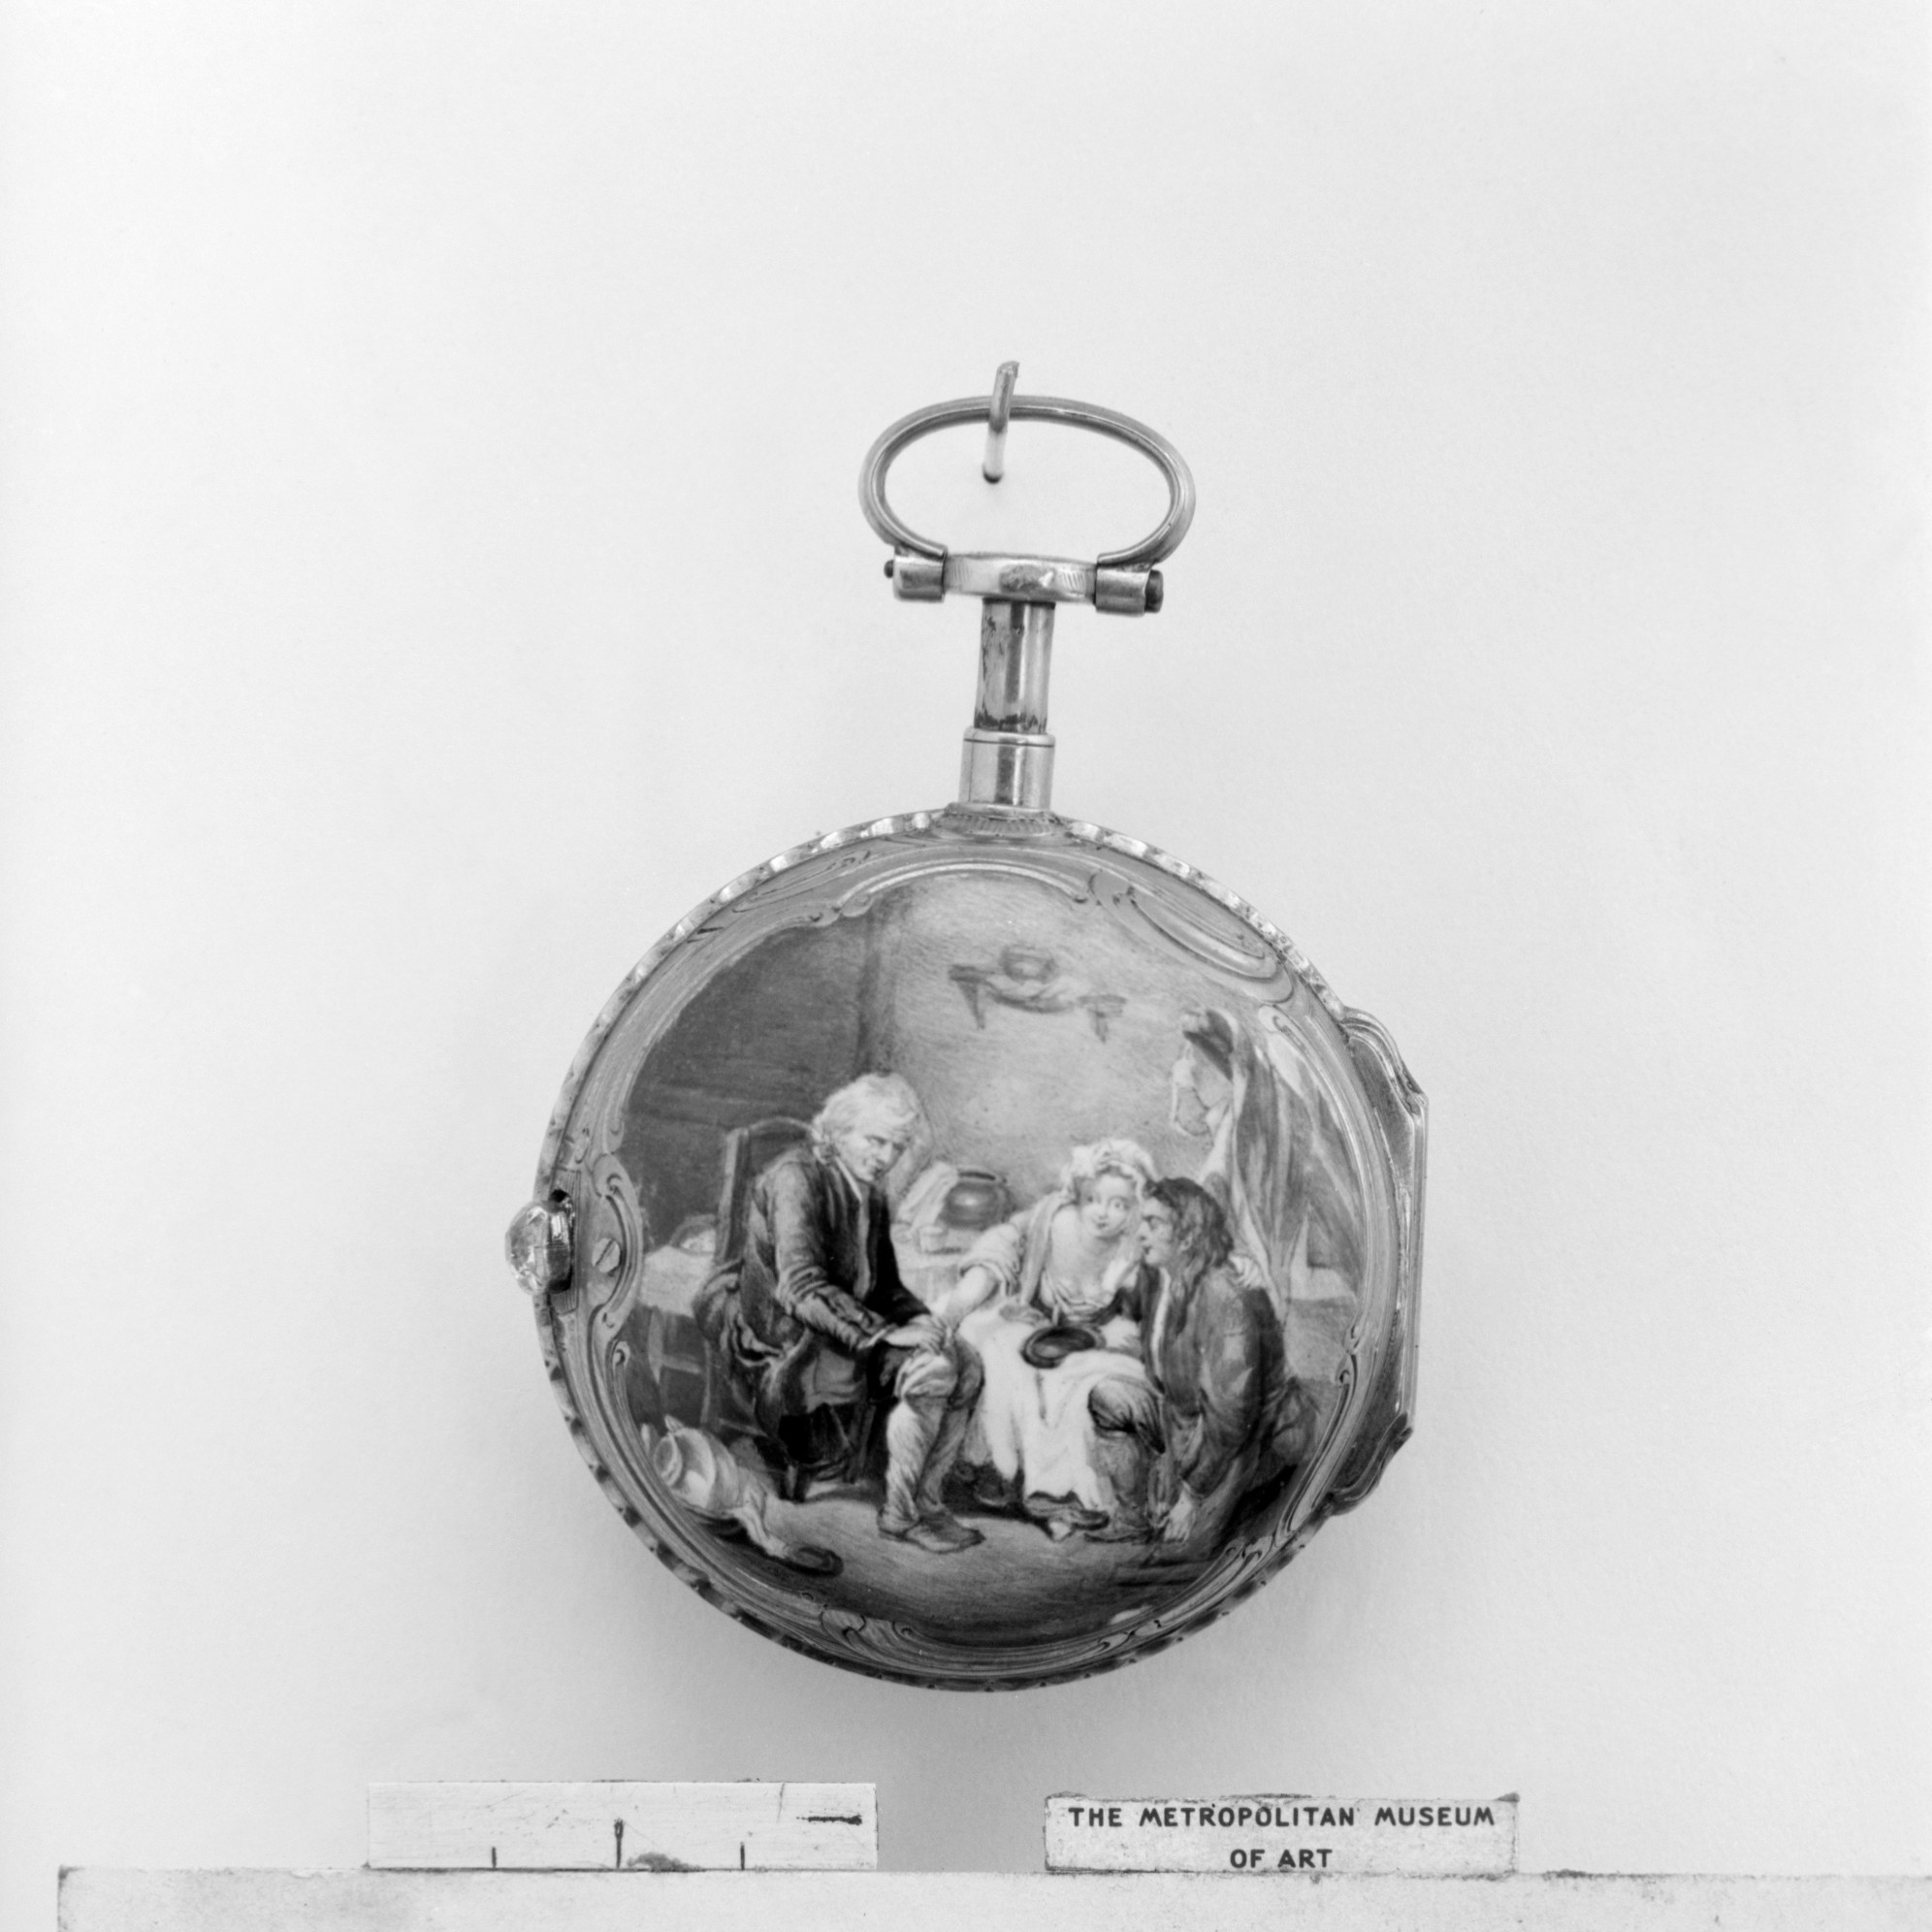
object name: repeater watch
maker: argand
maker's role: maker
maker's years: 1730-1807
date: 1770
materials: diamond, enamel, gold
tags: men,women